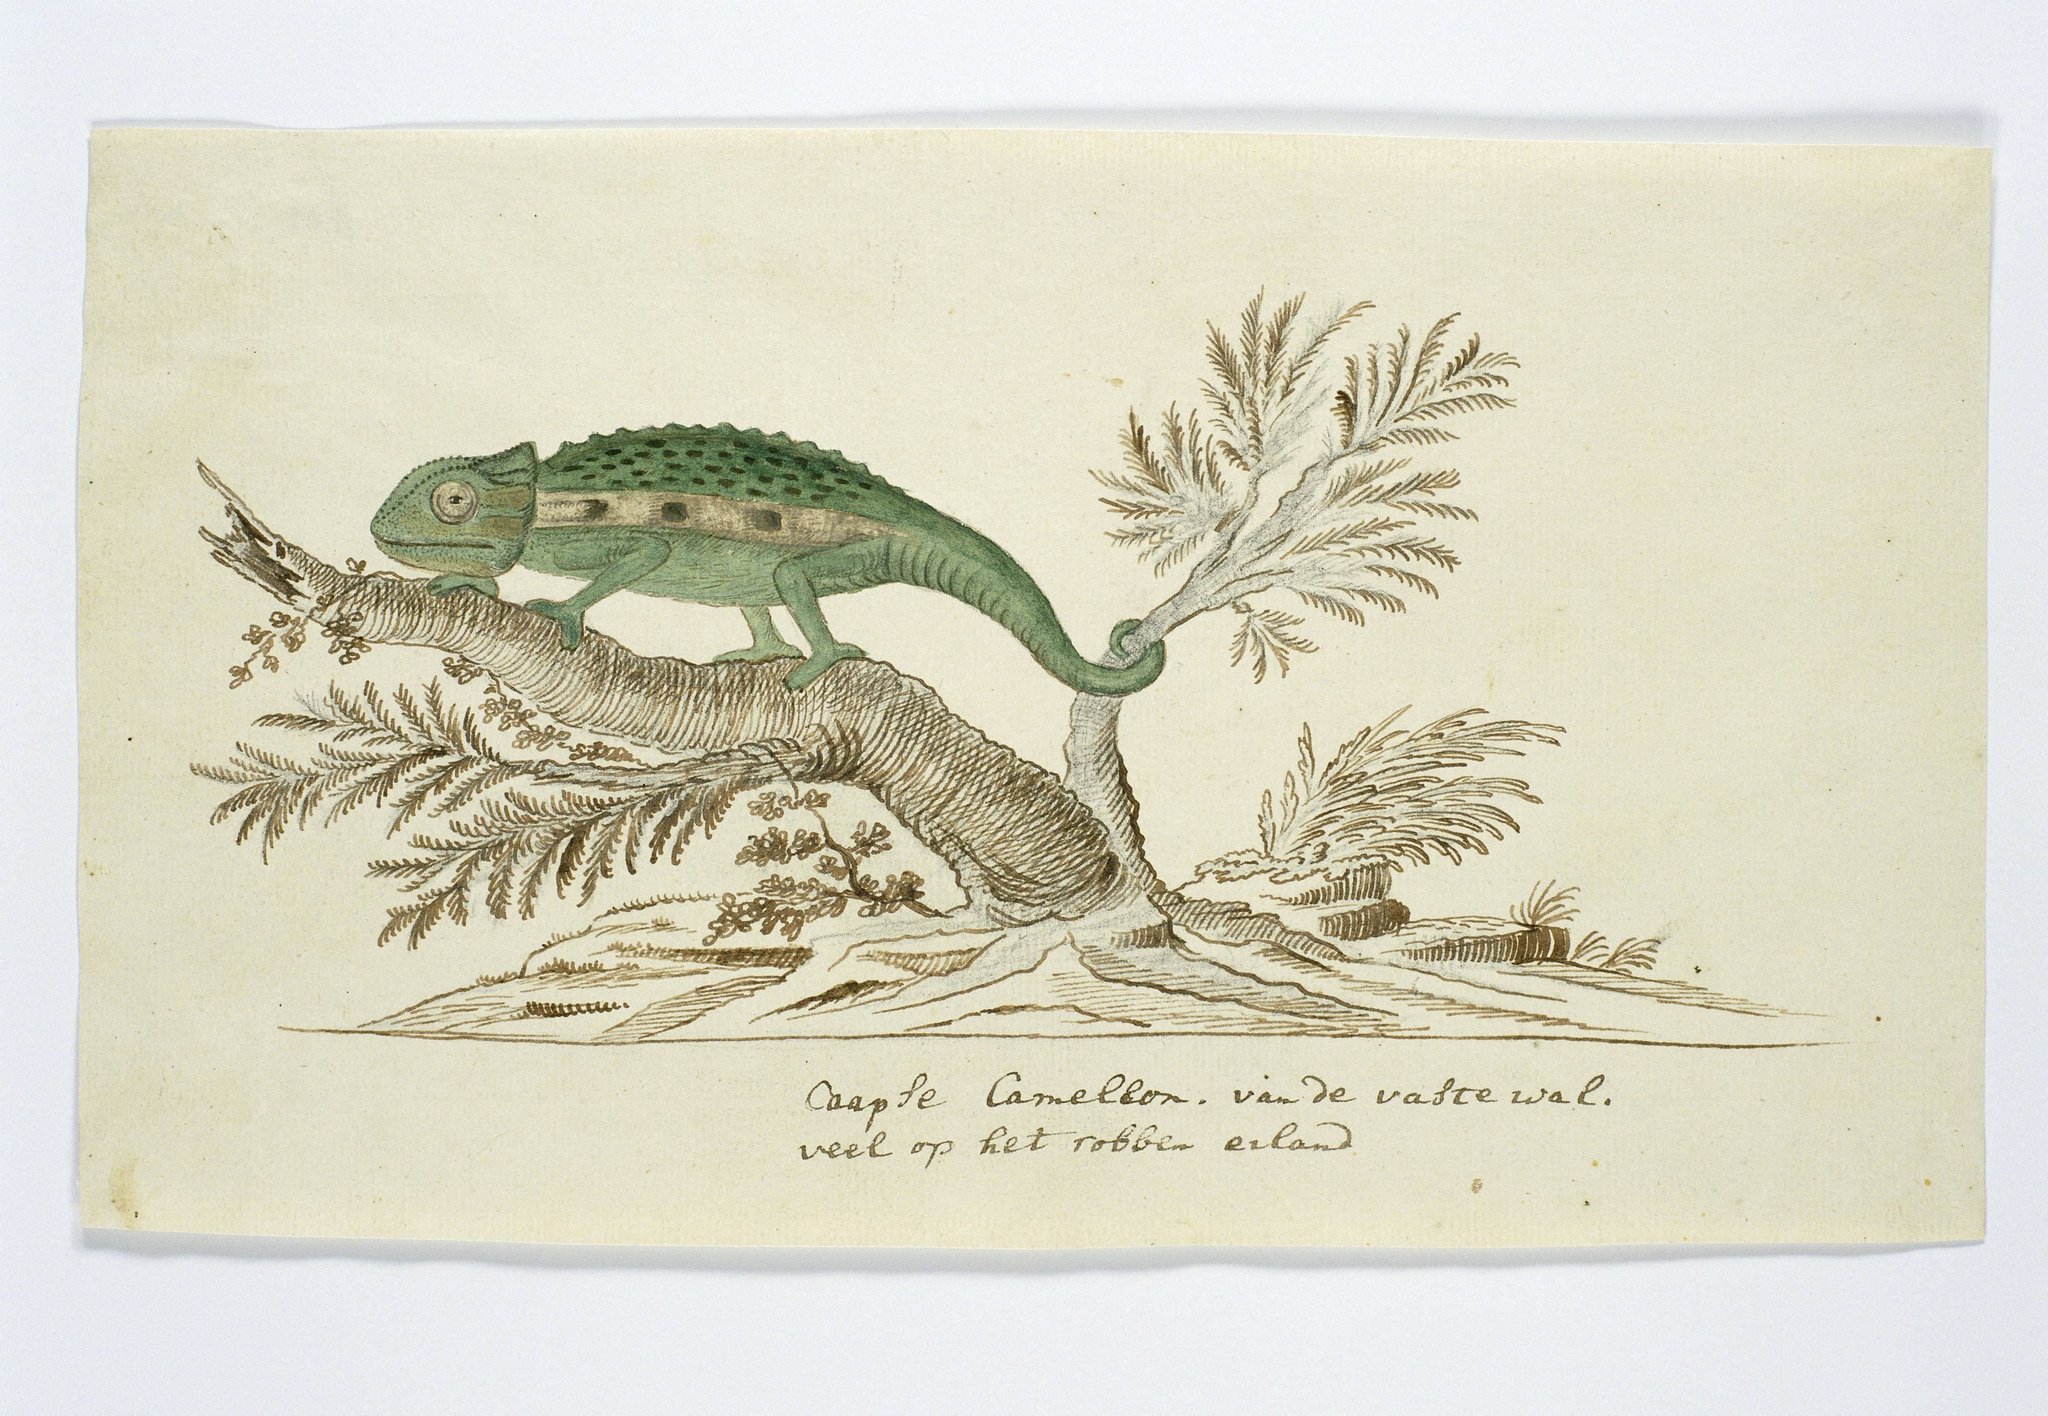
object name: dierstudie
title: Bradypodion pumilum (Cape dwarf chameleon)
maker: robert jacob gordon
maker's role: draughtsman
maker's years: 1743-1795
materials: chalk, ink, paper, pencil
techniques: brush, pen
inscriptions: annotation (possibly false): ‘Caapse Cameleon. van de vaste wal. / veel op het robben eiland’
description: Een Kaapse dwergkameleon die veel voorkomt op Robbeneiland.